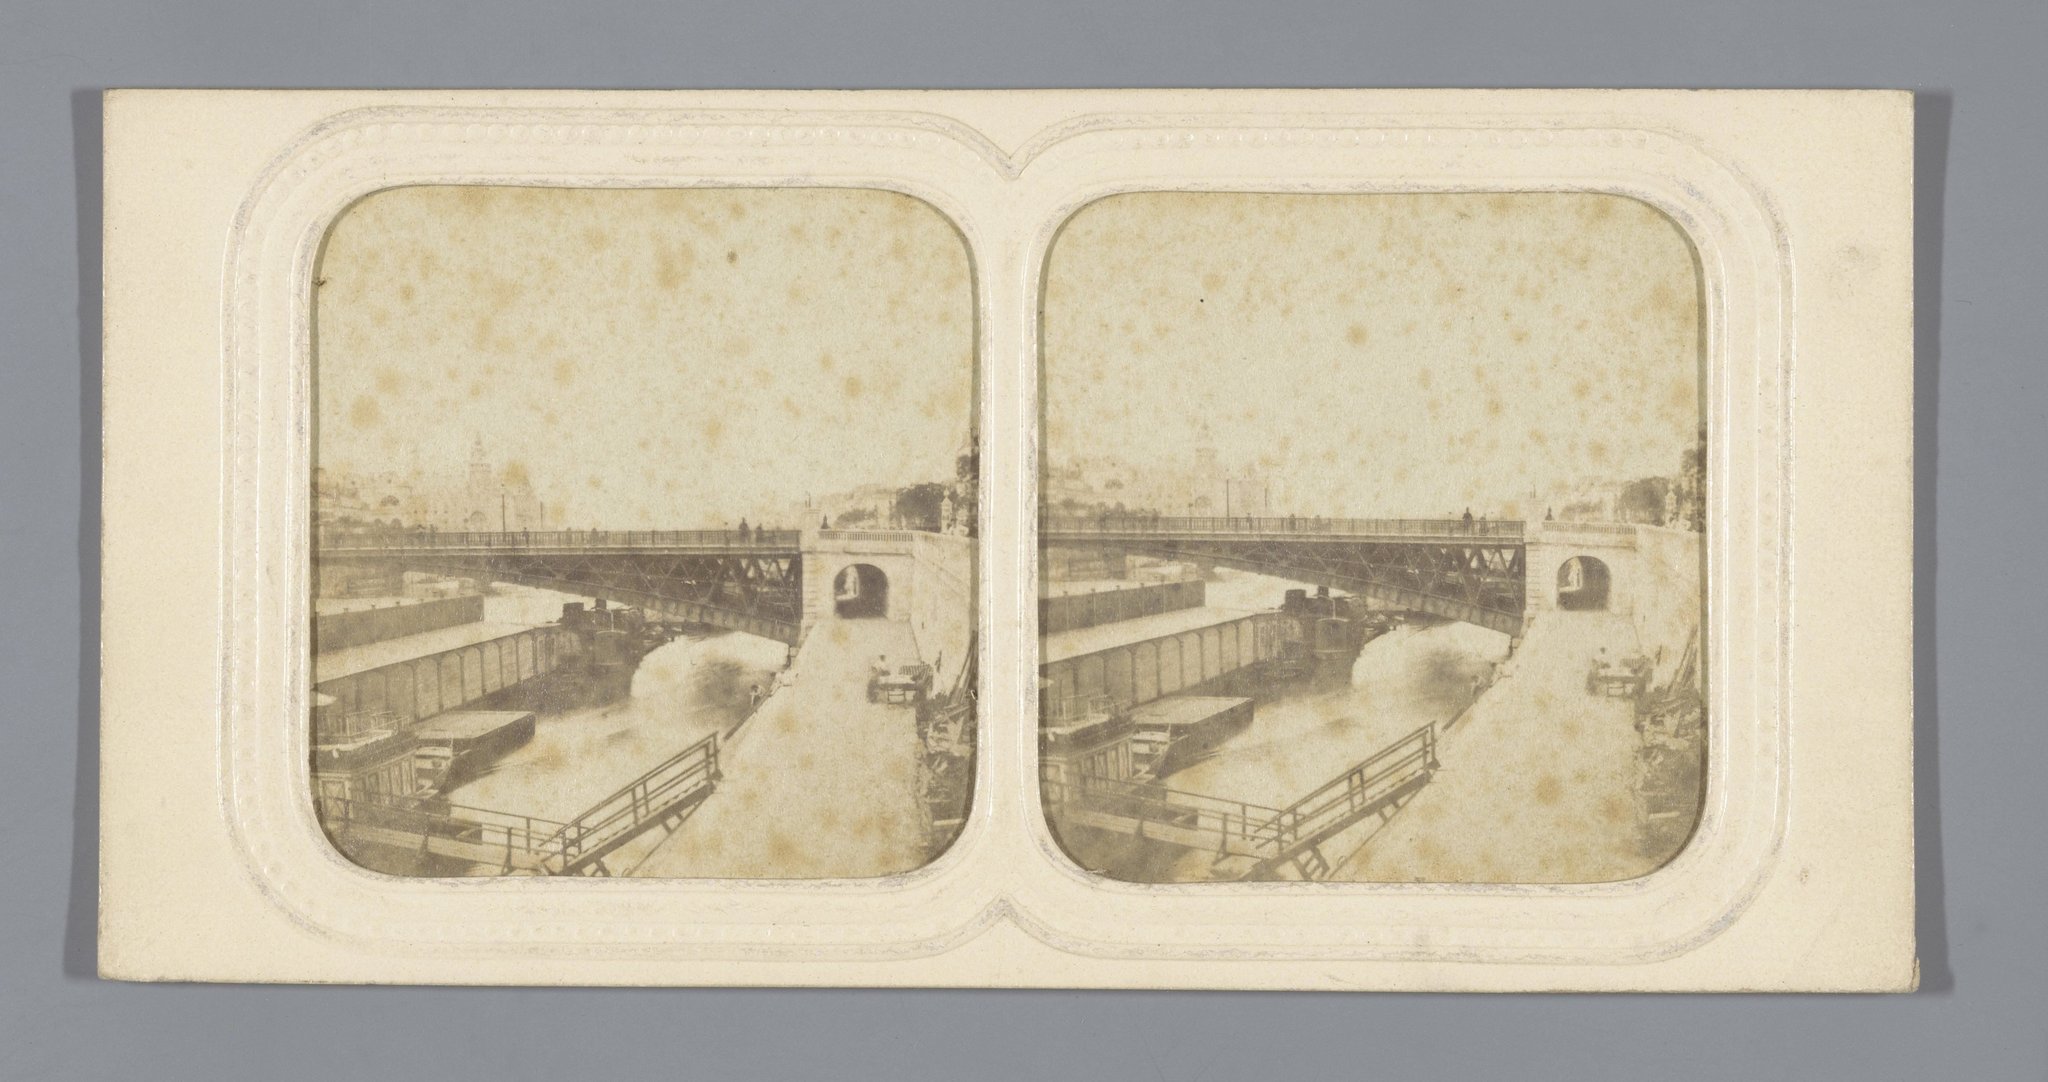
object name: tissue stereograph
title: Arcolebrug over de Seine in Parijs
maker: Anonymous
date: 1856-1875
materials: cardboard, paper, photographic support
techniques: albumen print, hand coloring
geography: paris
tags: bridge in city across river, canal, etc.